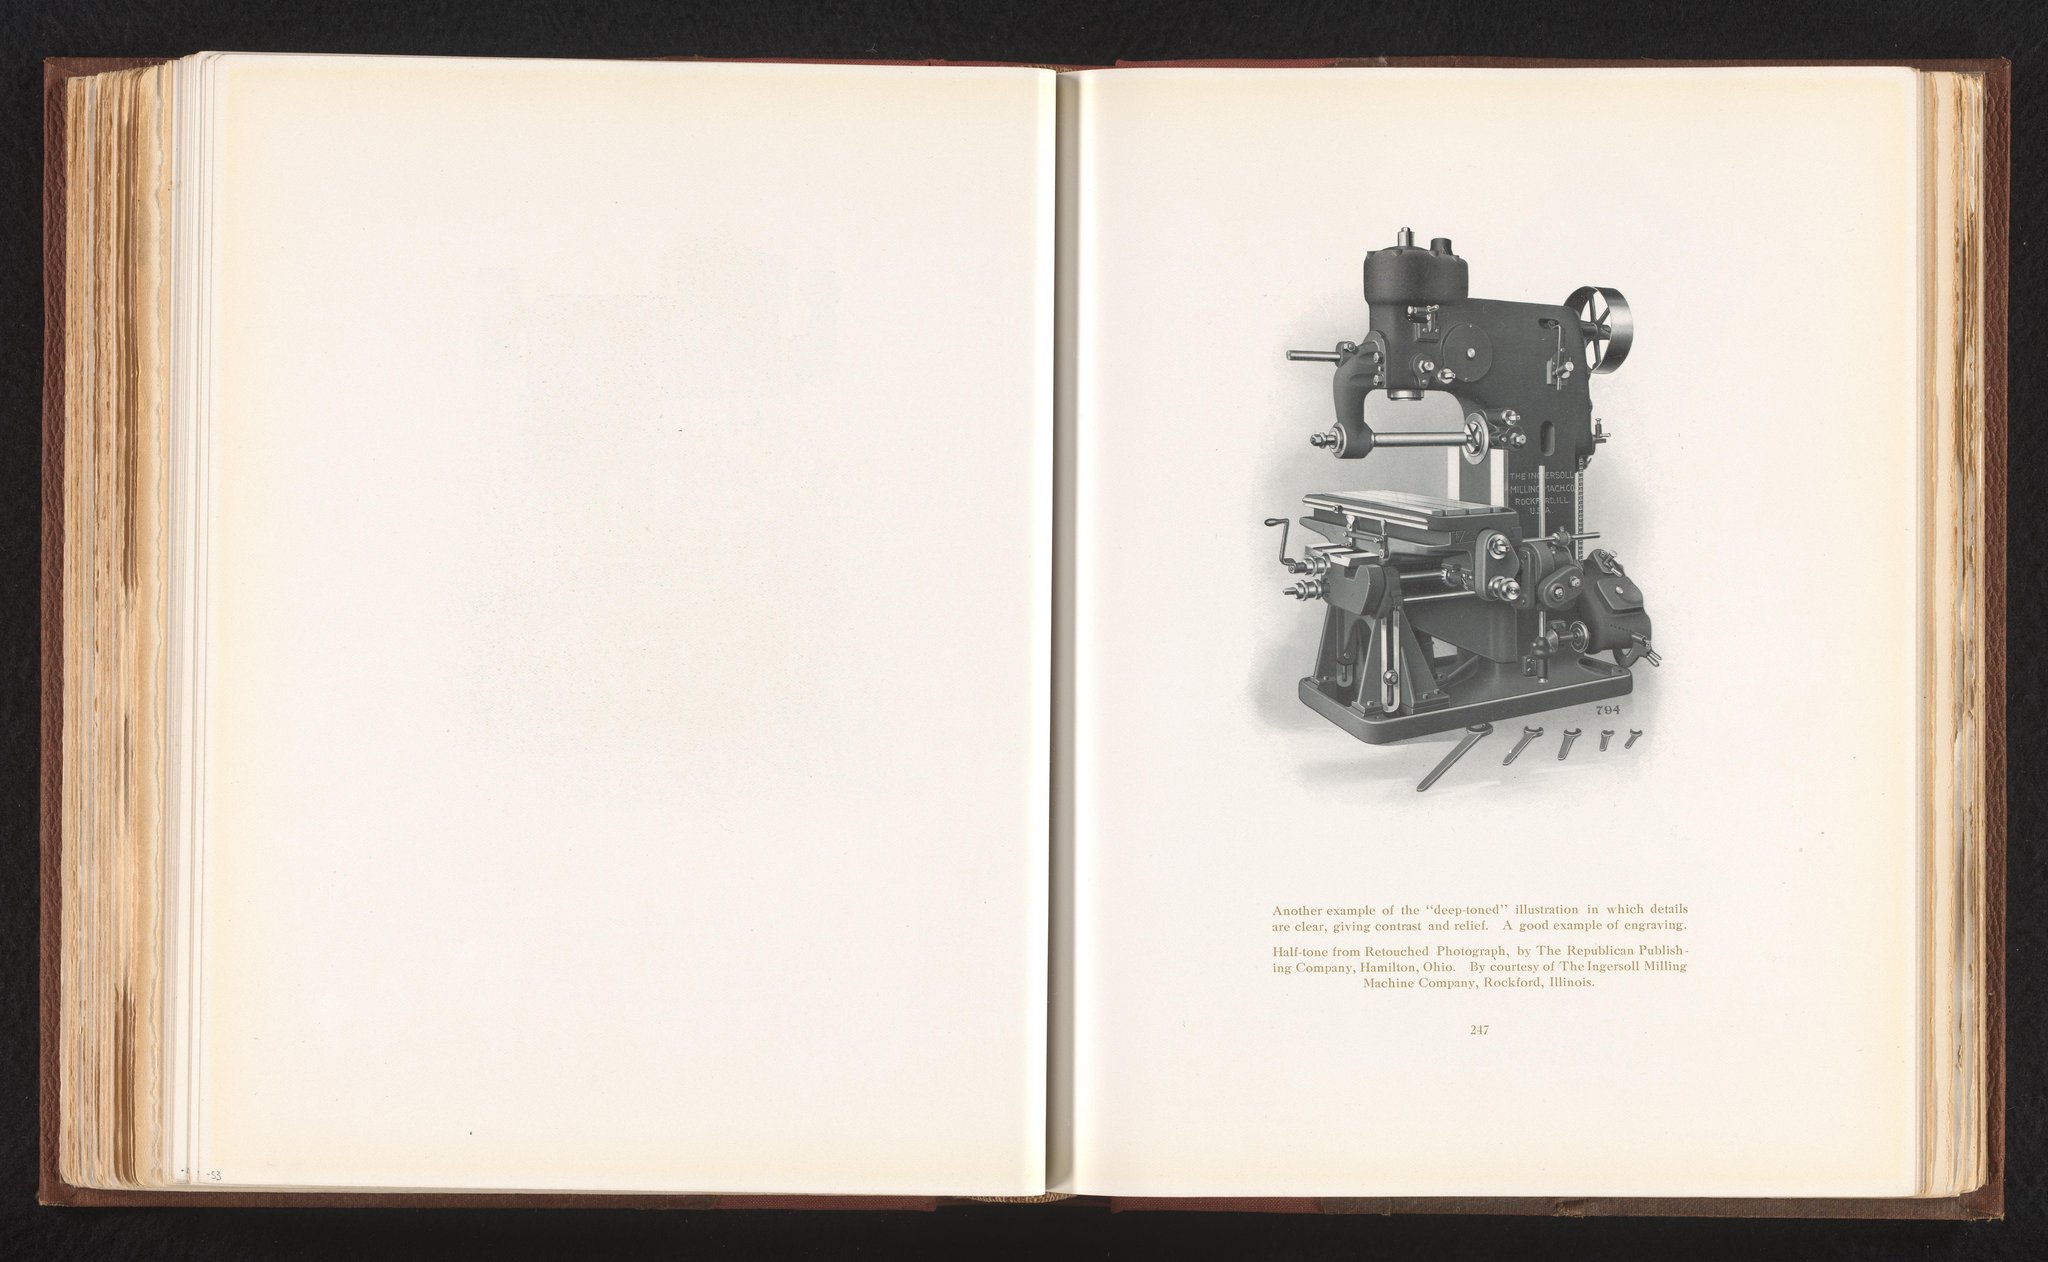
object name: page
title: Machine van de Ingersoll Milling Machine Company te Rockford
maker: Anonymous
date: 1904-1909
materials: paper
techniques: autotype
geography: hamilton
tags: machines, engines ~ crafts and industries